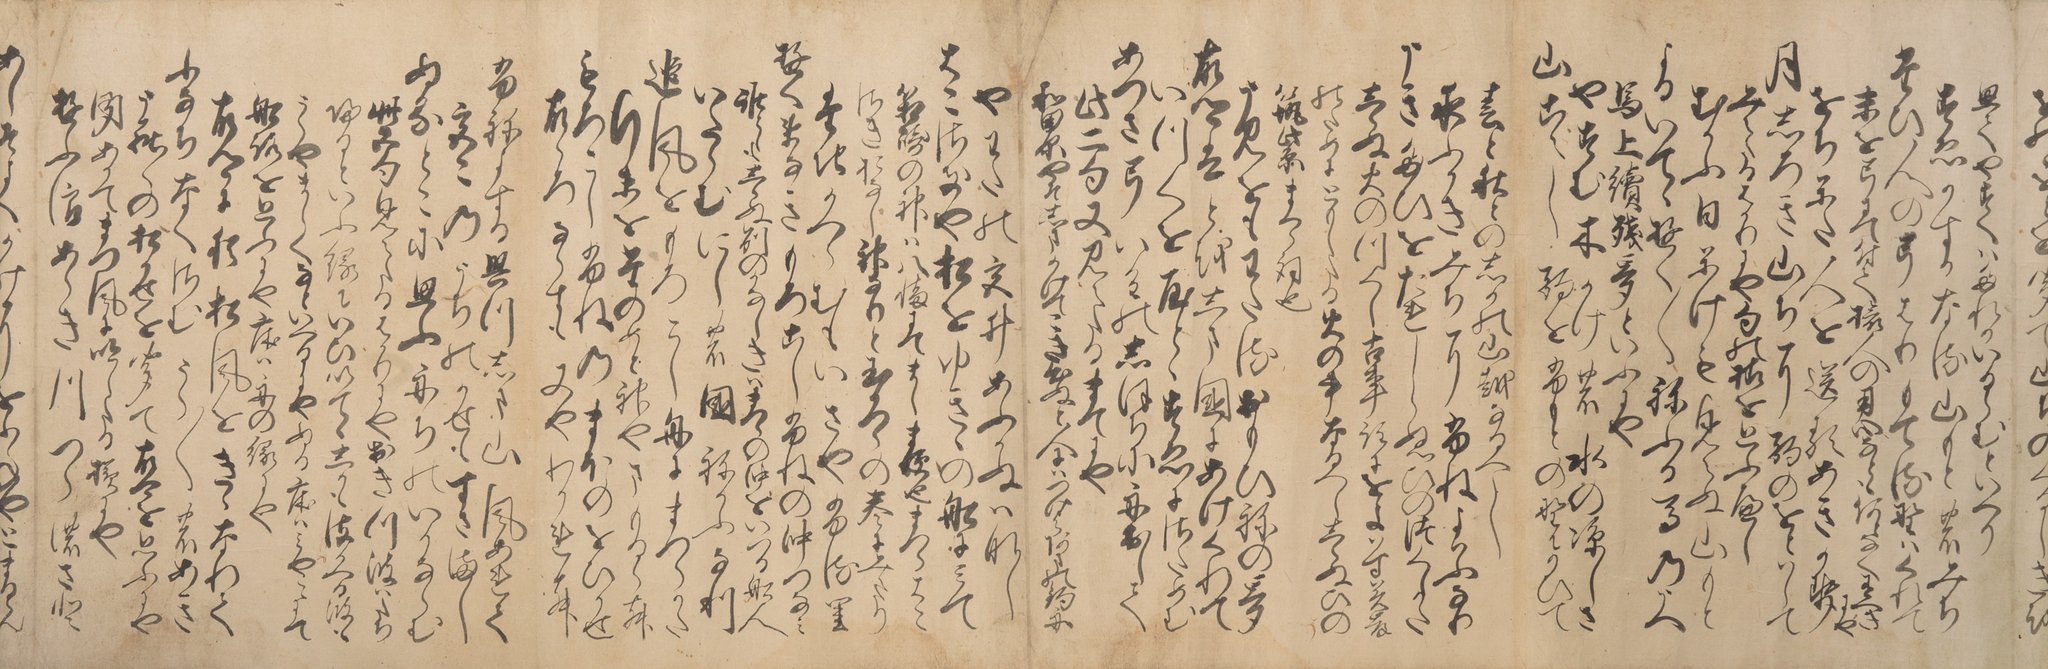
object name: handscroll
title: Manuscript Version of the “Travel” Section of the Linked Verse (Renga) Collection “Aged Leaves” (Wakuraba), compiled by Sōgi (1421–1502)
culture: japanese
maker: ryūkō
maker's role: artist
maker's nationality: japanese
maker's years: 1500-1573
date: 1533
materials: ink, paper